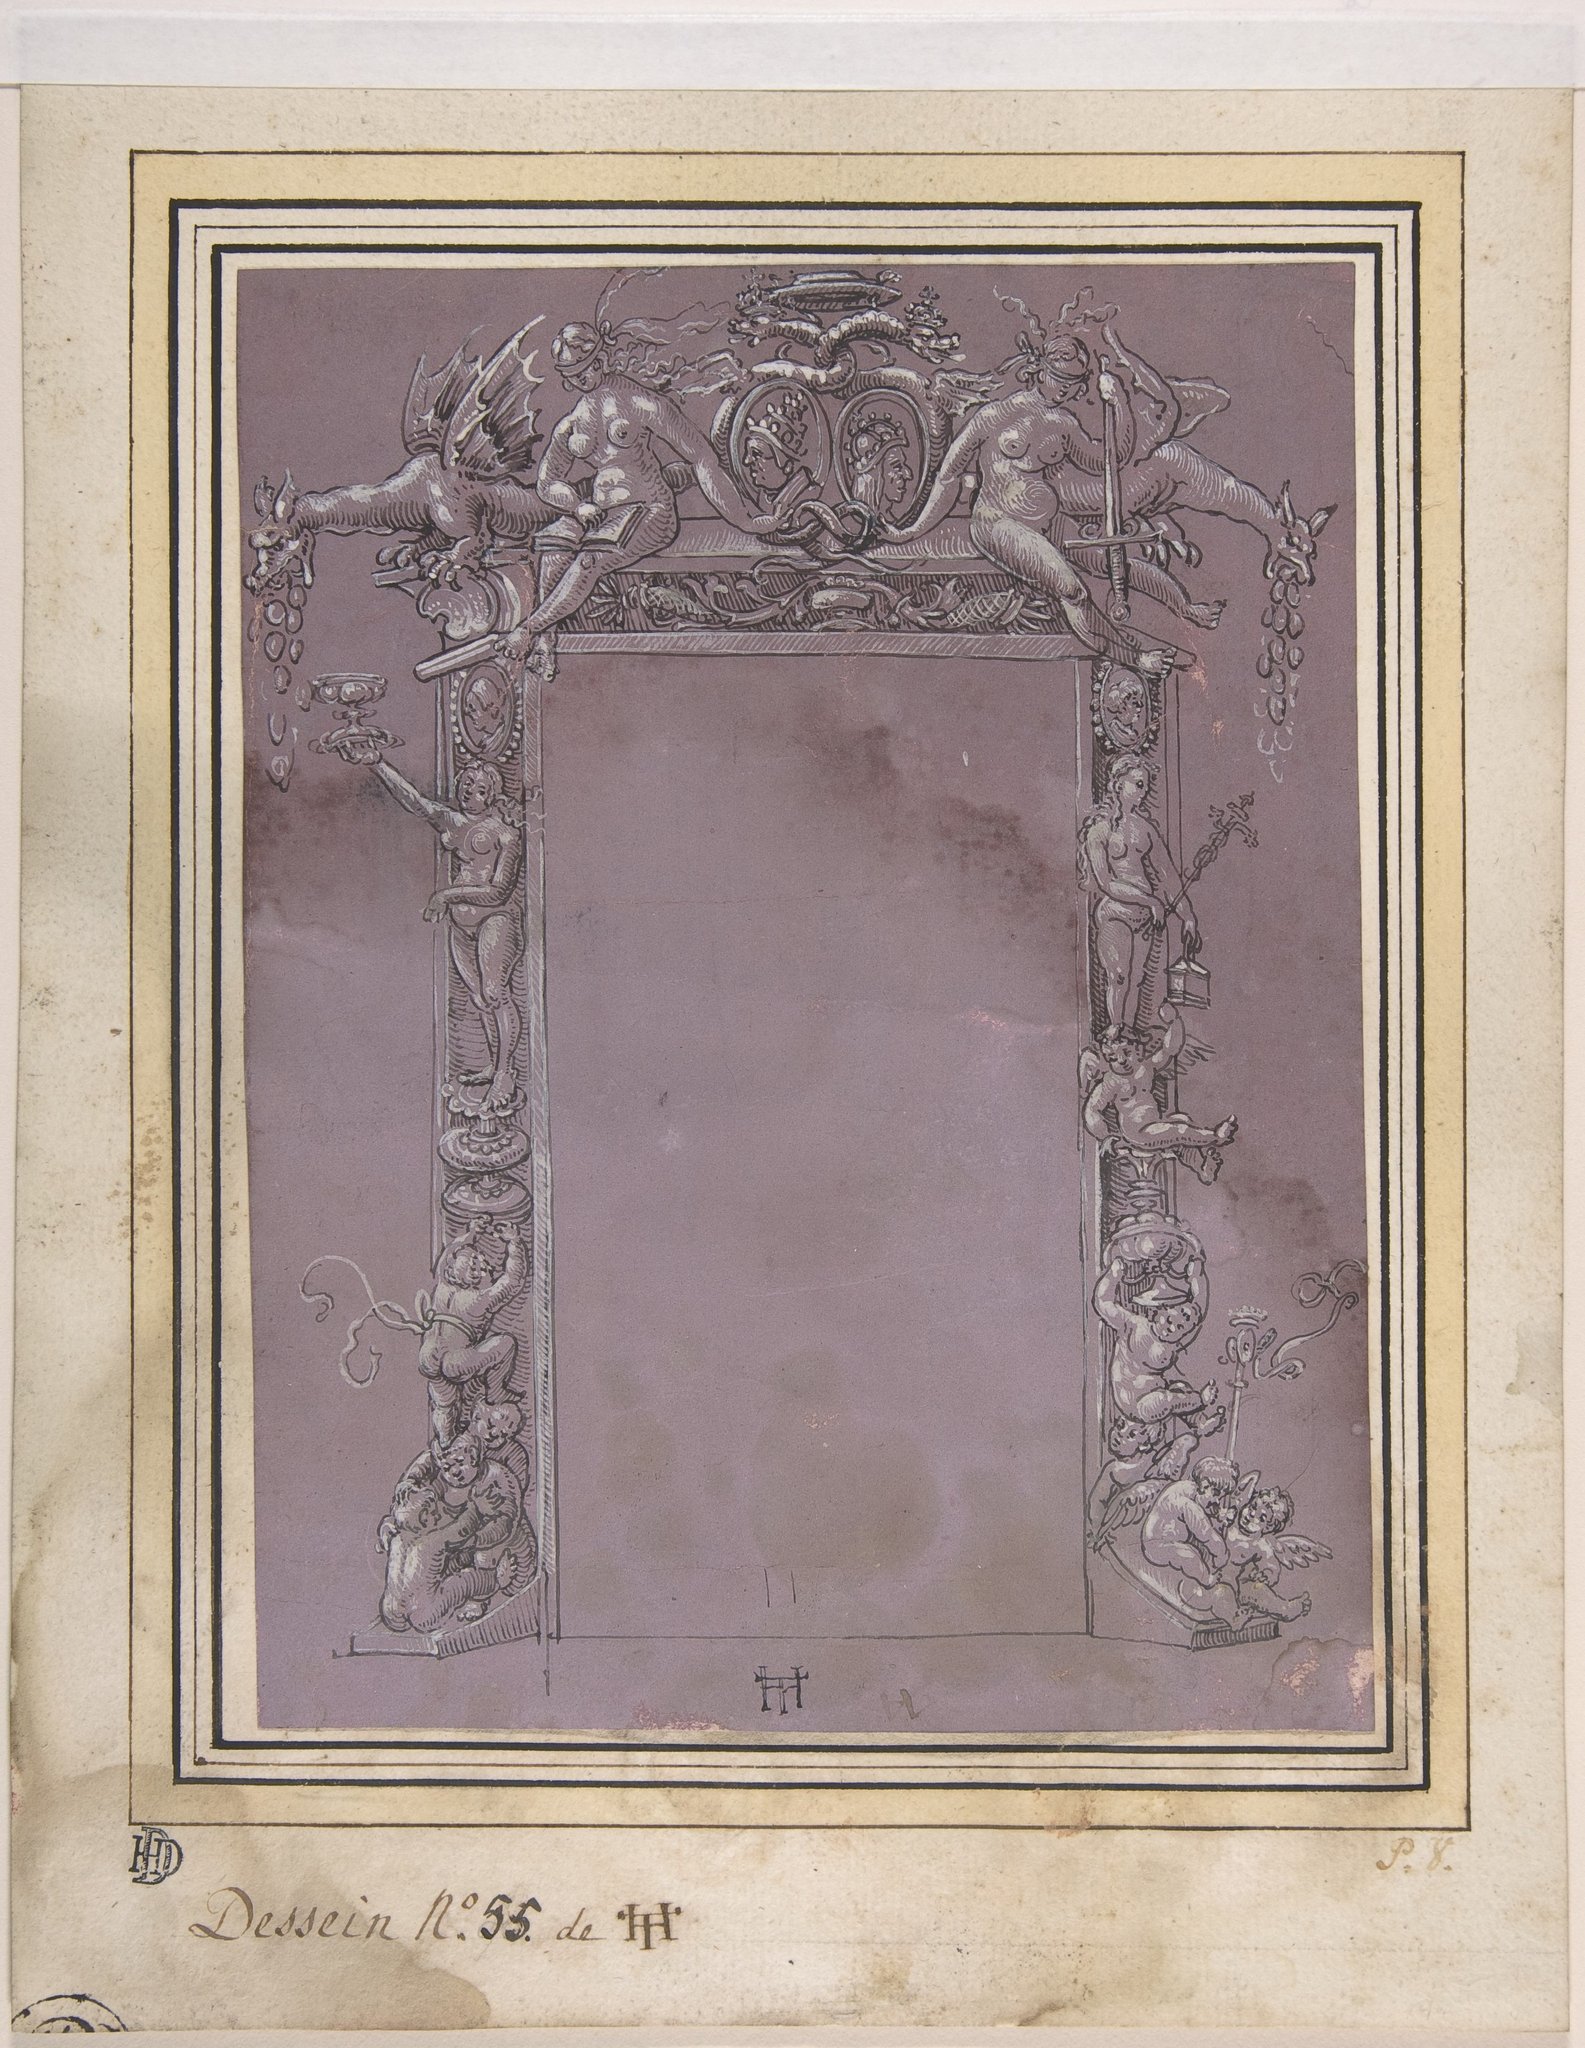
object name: collection ornament architecture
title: Design for a Doorway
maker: monogrammist ht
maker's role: artist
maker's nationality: german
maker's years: 16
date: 1501-1600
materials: ink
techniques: heightening, pen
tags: doorways,female nudes